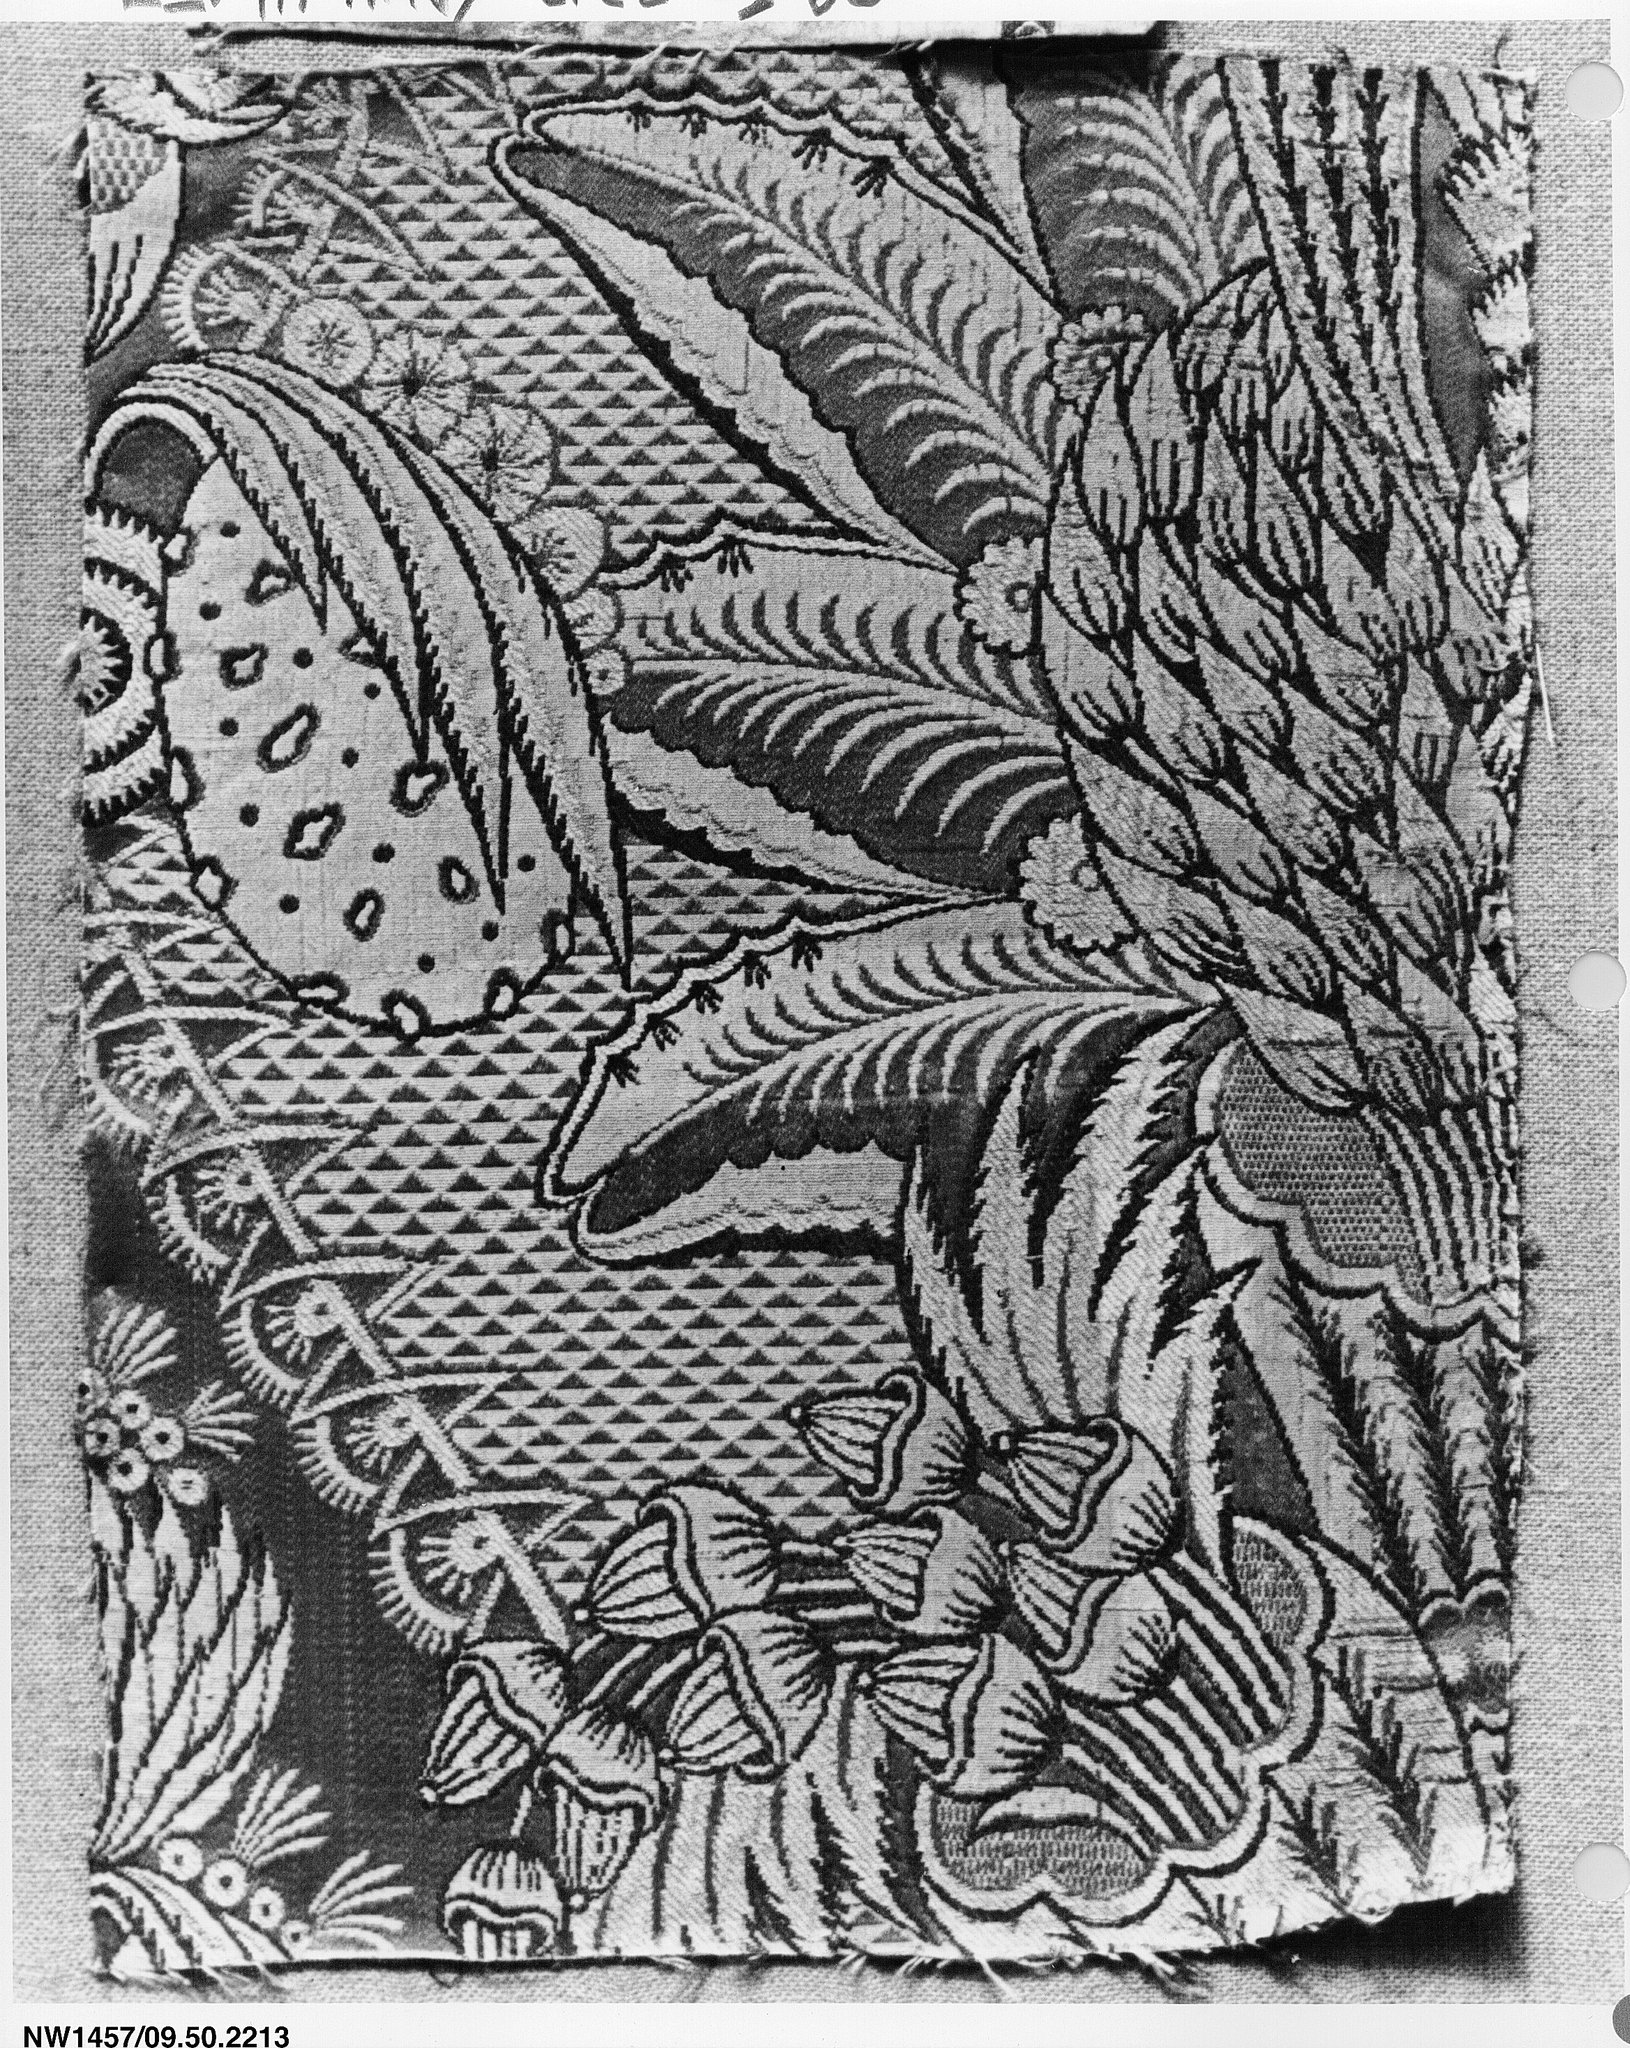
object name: piece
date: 1720-1725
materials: silk